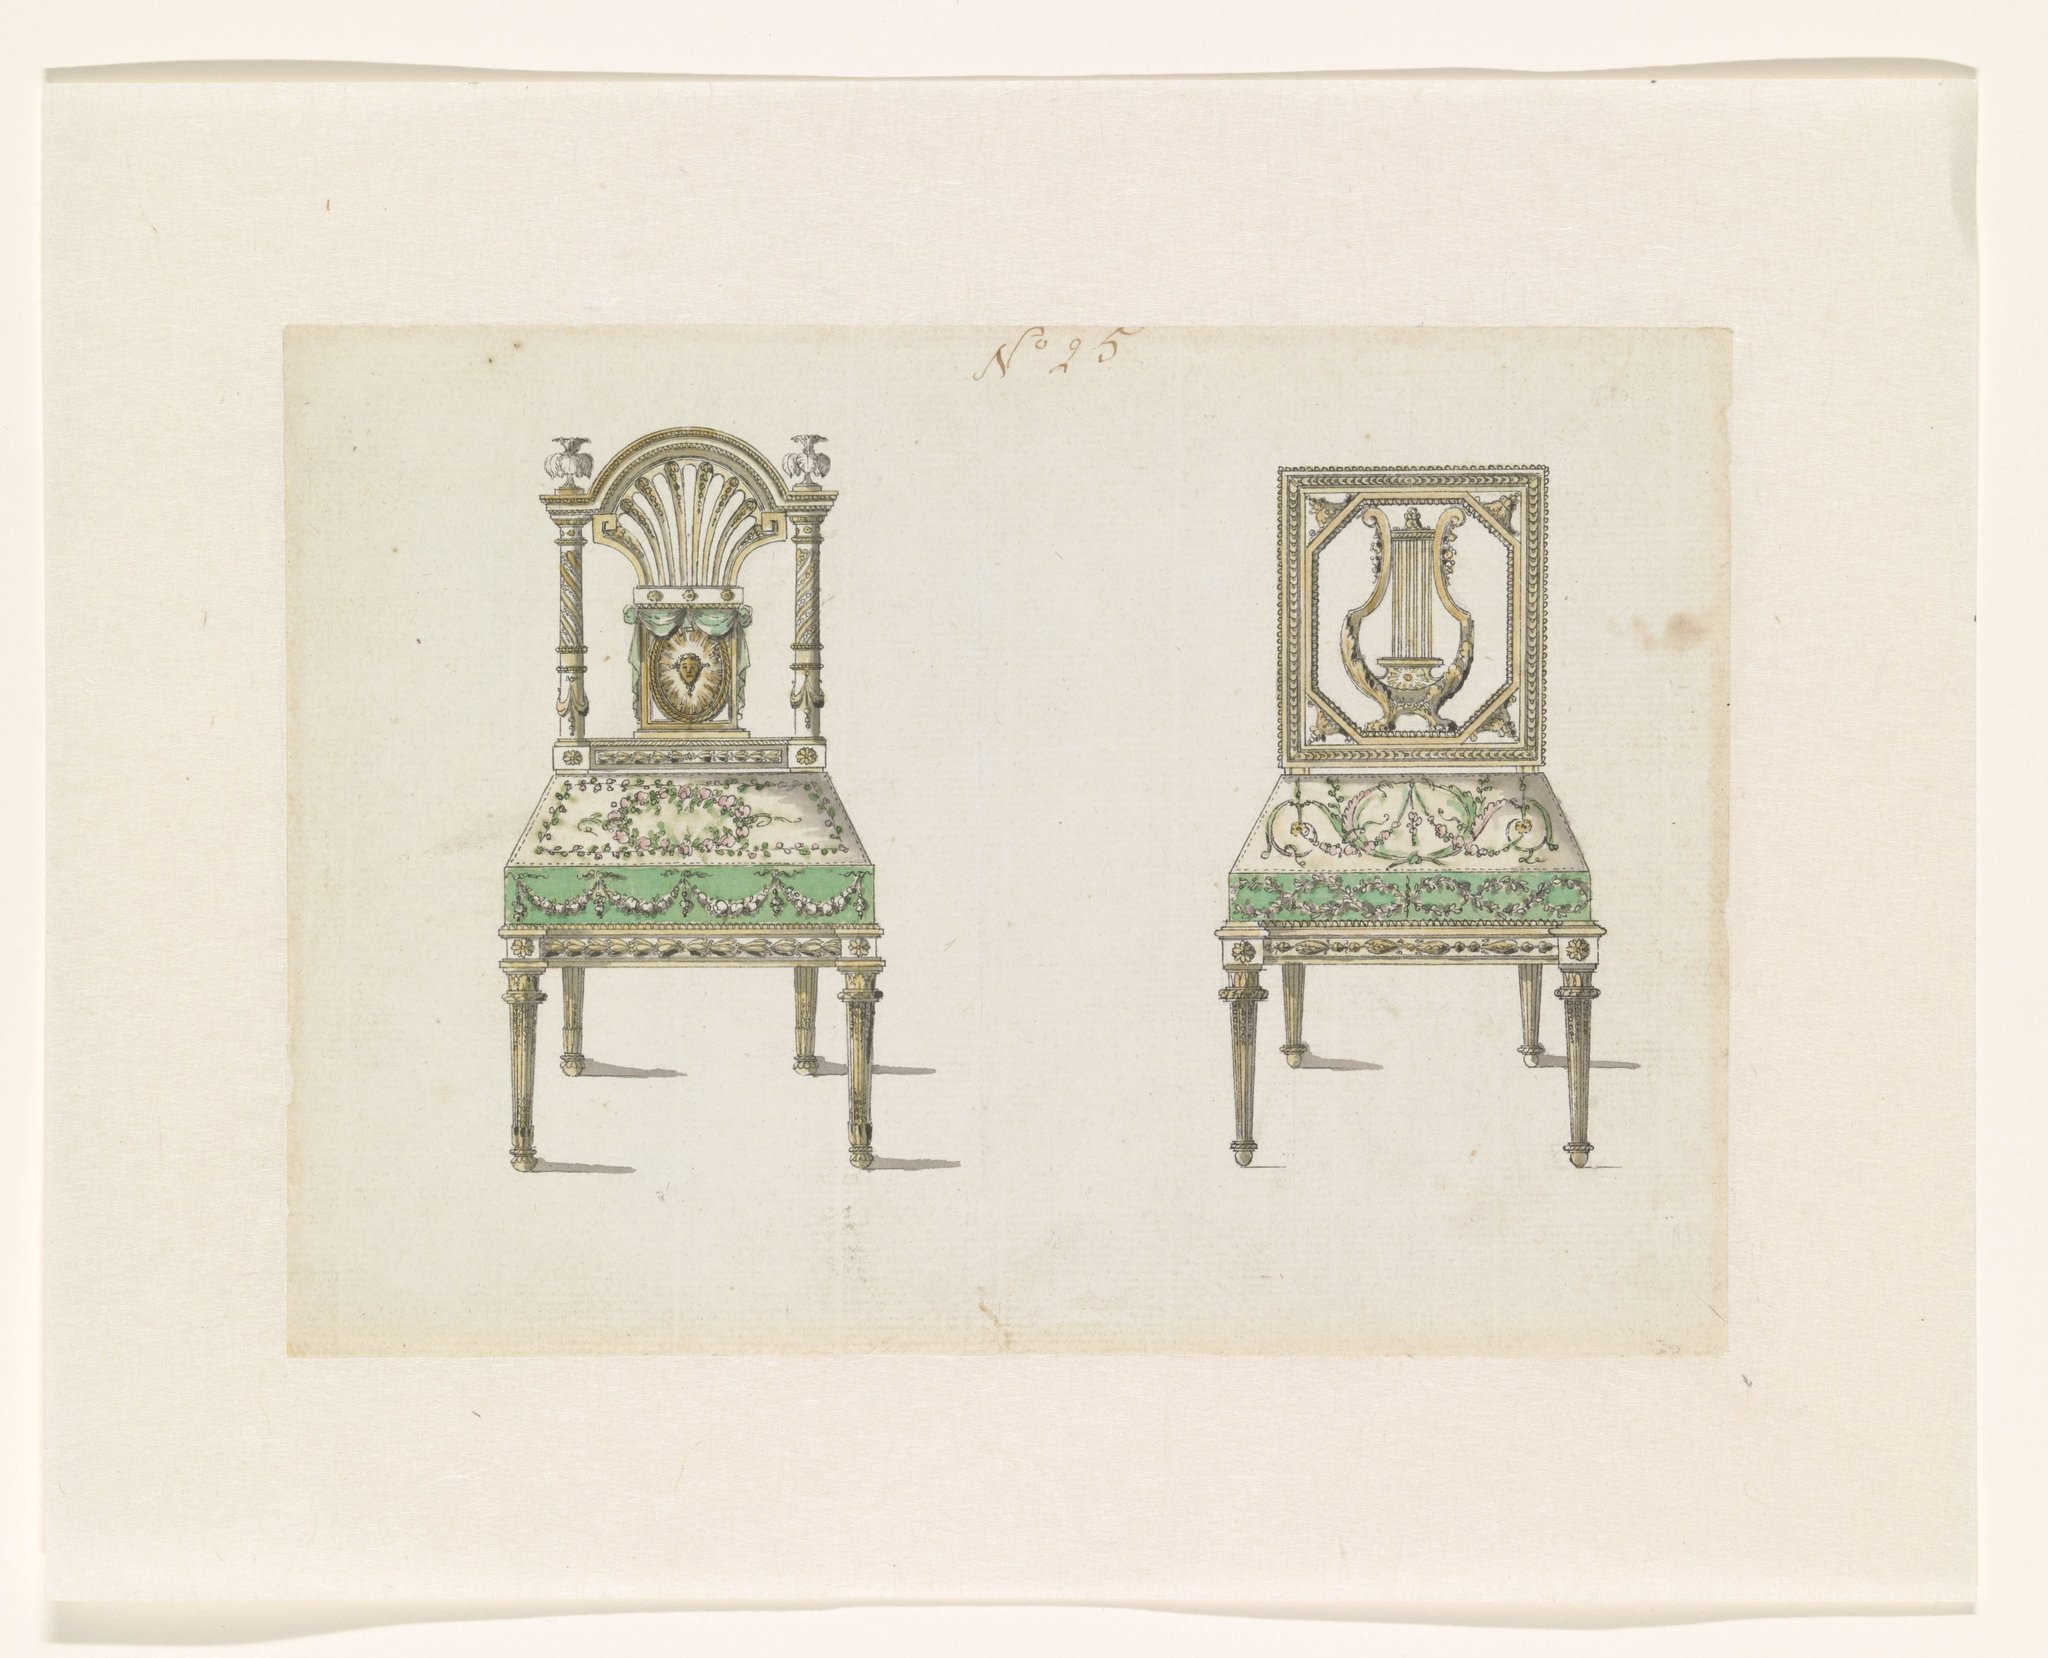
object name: design drawing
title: Two chairs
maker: Anonymous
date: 1780-1785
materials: ink, paper, watercolor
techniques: brush, pen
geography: paris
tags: chair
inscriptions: annotation: ‘No. 25’, : ‘12’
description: The drawing, which is numbered ‘25’, was probably commissioned by a dealer or maître-tapissier (upholsterer) as part of a kind of catalogue from which prospective customers could make their selection. The drawing room from the Kops house in Haarlem (displayed in the gallery next door) has somewhat similar chairs, upholstered in closely related fashion.